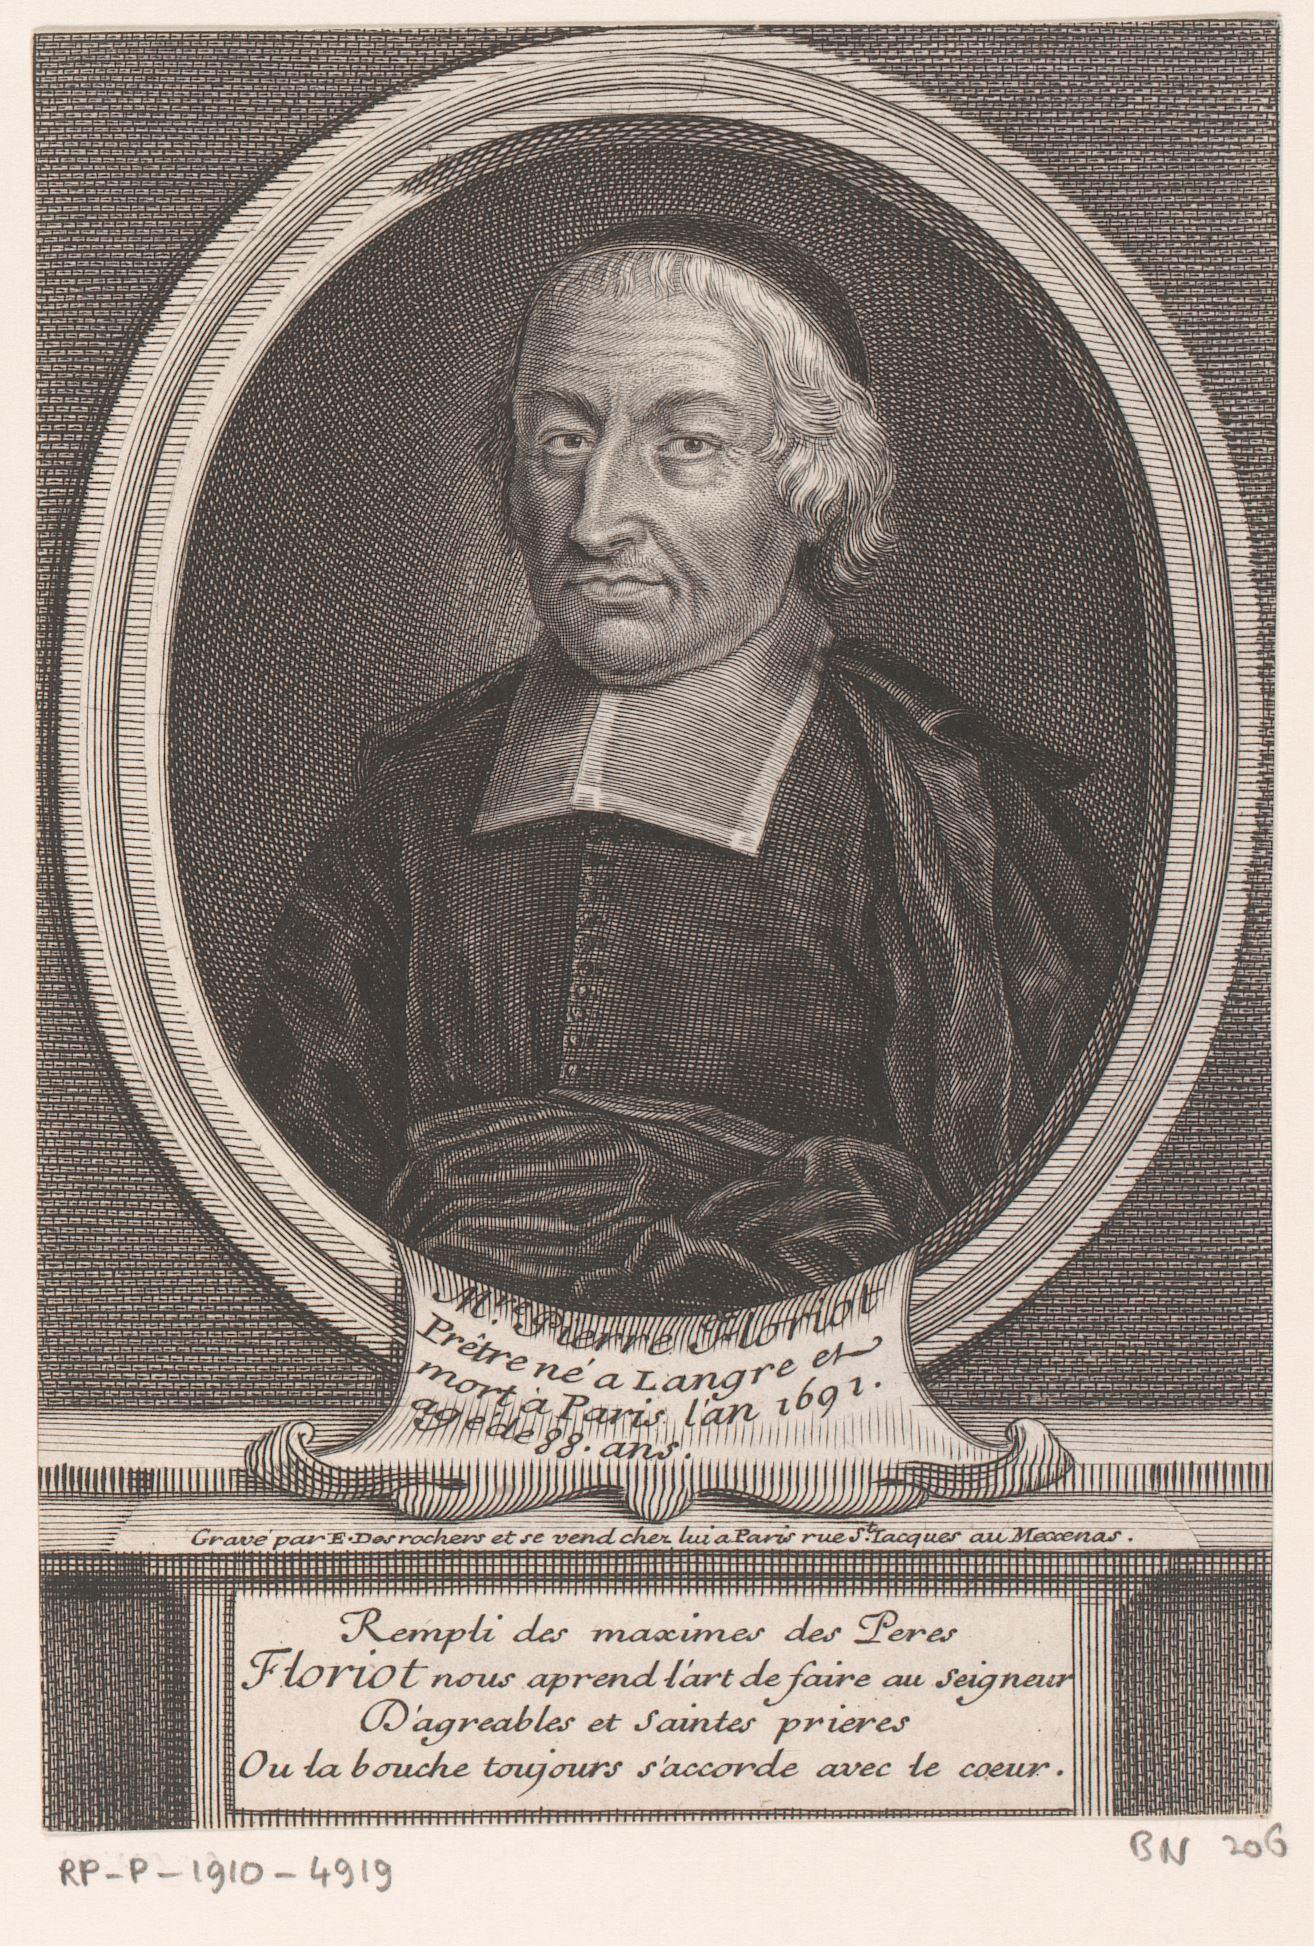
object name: print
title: Recueil de portraits (...)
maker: étienne desrochers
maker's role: print maker, publisher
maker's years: 1668-1741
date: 1726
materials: paper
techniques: engraving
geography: paris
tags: paris, historical persons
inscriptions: collector's mark: Lugt 2228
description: Behoort waarschijnlijk tot een serie portretten, grotendeels door Etienne Desrochers, getiteld: 'Recueil de portraits de personnes qui se sont distinguées tant dans les Armes que dans Belles-Lettres et les Arts, comme aussi la famille royale de France et autres cours étrangères'. De serie werd initieel uitgegeven door Desrochers en aangekondigd in 'Mercure' in mei 1726, p. 985. Echter was Desrochers reeds enkele jaren eerder begonnen met het uitgeven van de serie. Na de dood van Desrochers werd de serie voortgezet door Gilles Edme Petit. Een latere staat werd uitgegeven door Jean François Daumont in Parijs.